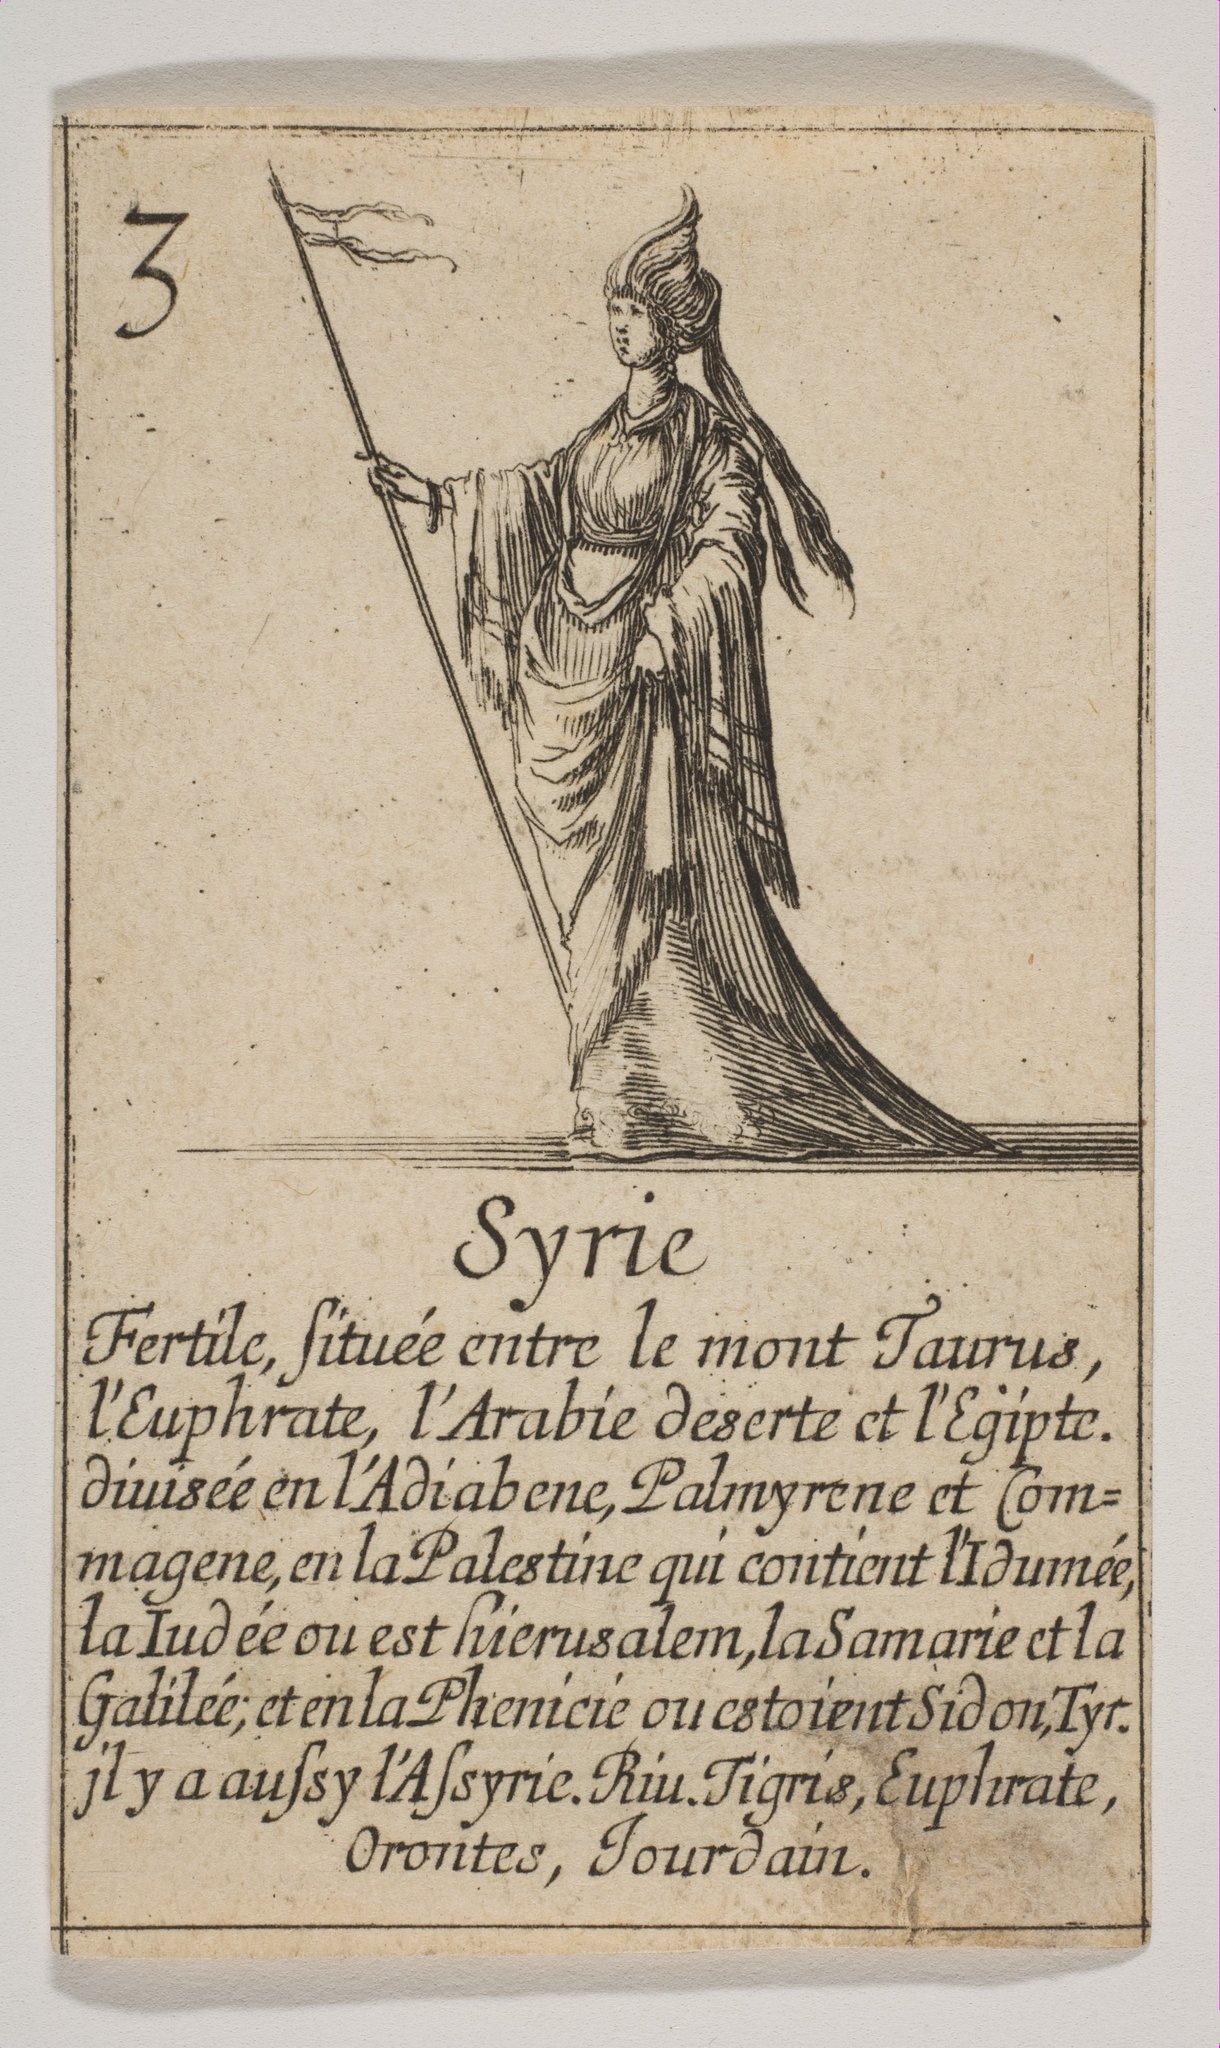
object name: print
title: Syrie, from "Jeu de la Géographie"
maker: stefano della bella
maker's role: artist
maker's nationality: italian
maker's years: 1610-1664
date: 1644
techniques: etching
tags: human figures